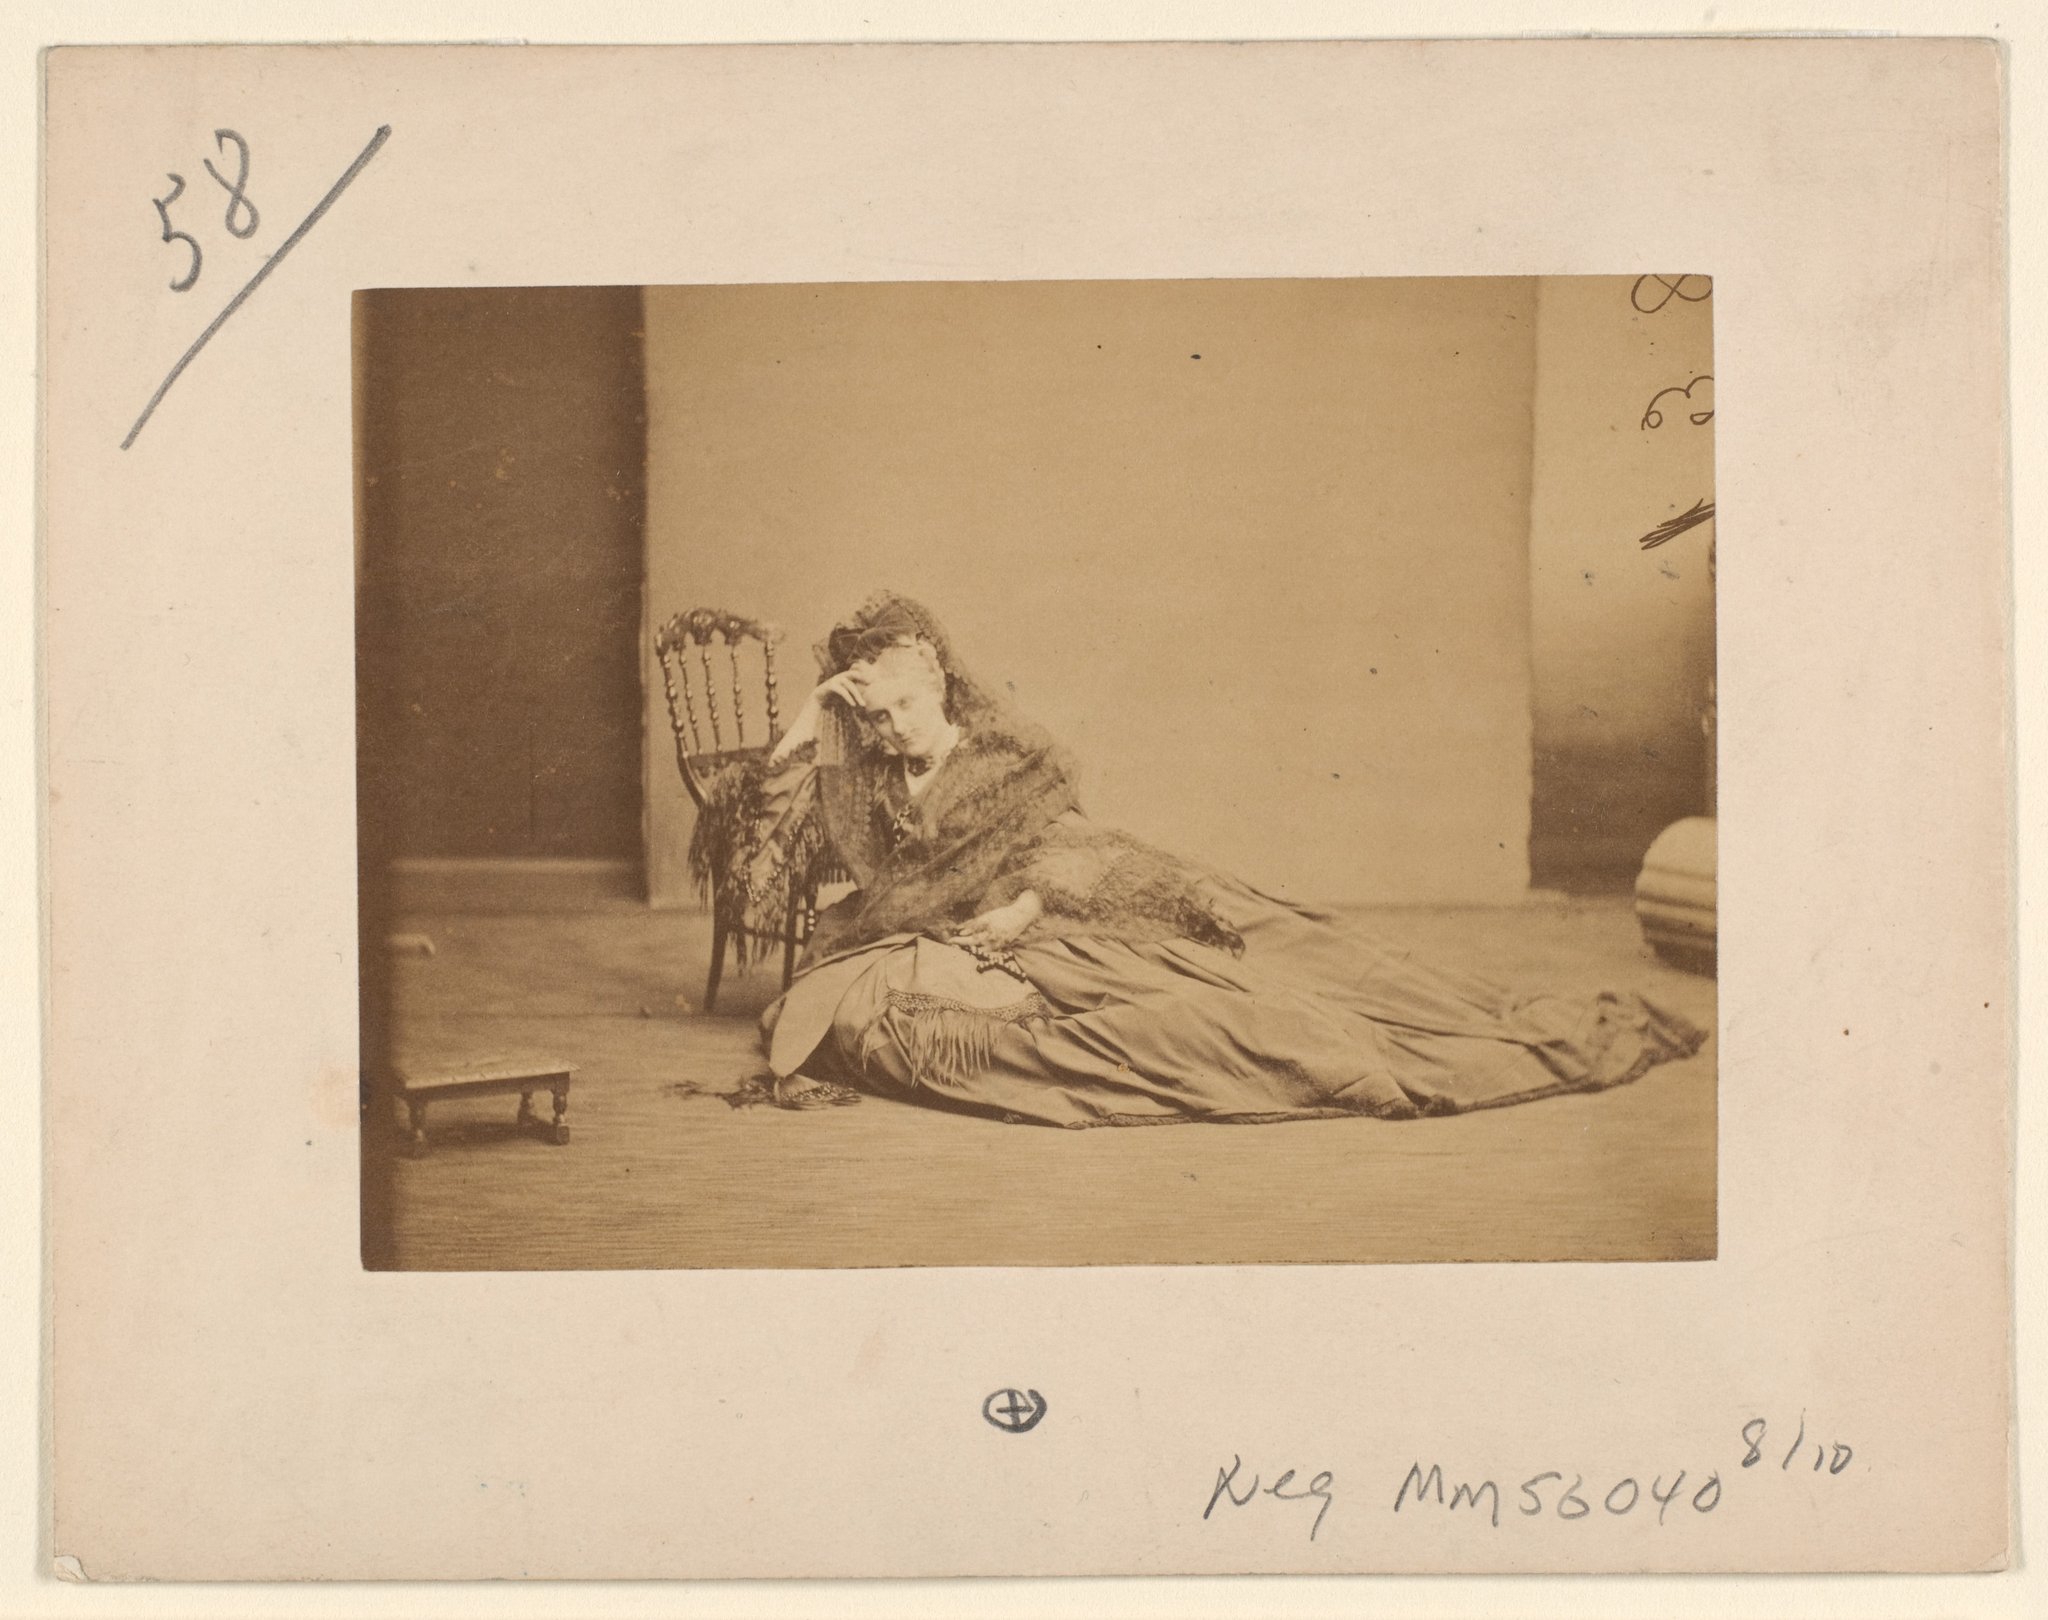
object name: photograph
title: Le chapelet (autre)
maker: pierre-louis pierson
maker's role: artist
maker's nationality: french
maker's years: 1822-1913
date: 1860-1869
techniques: albumen silver print, glass negative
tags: women,chairs